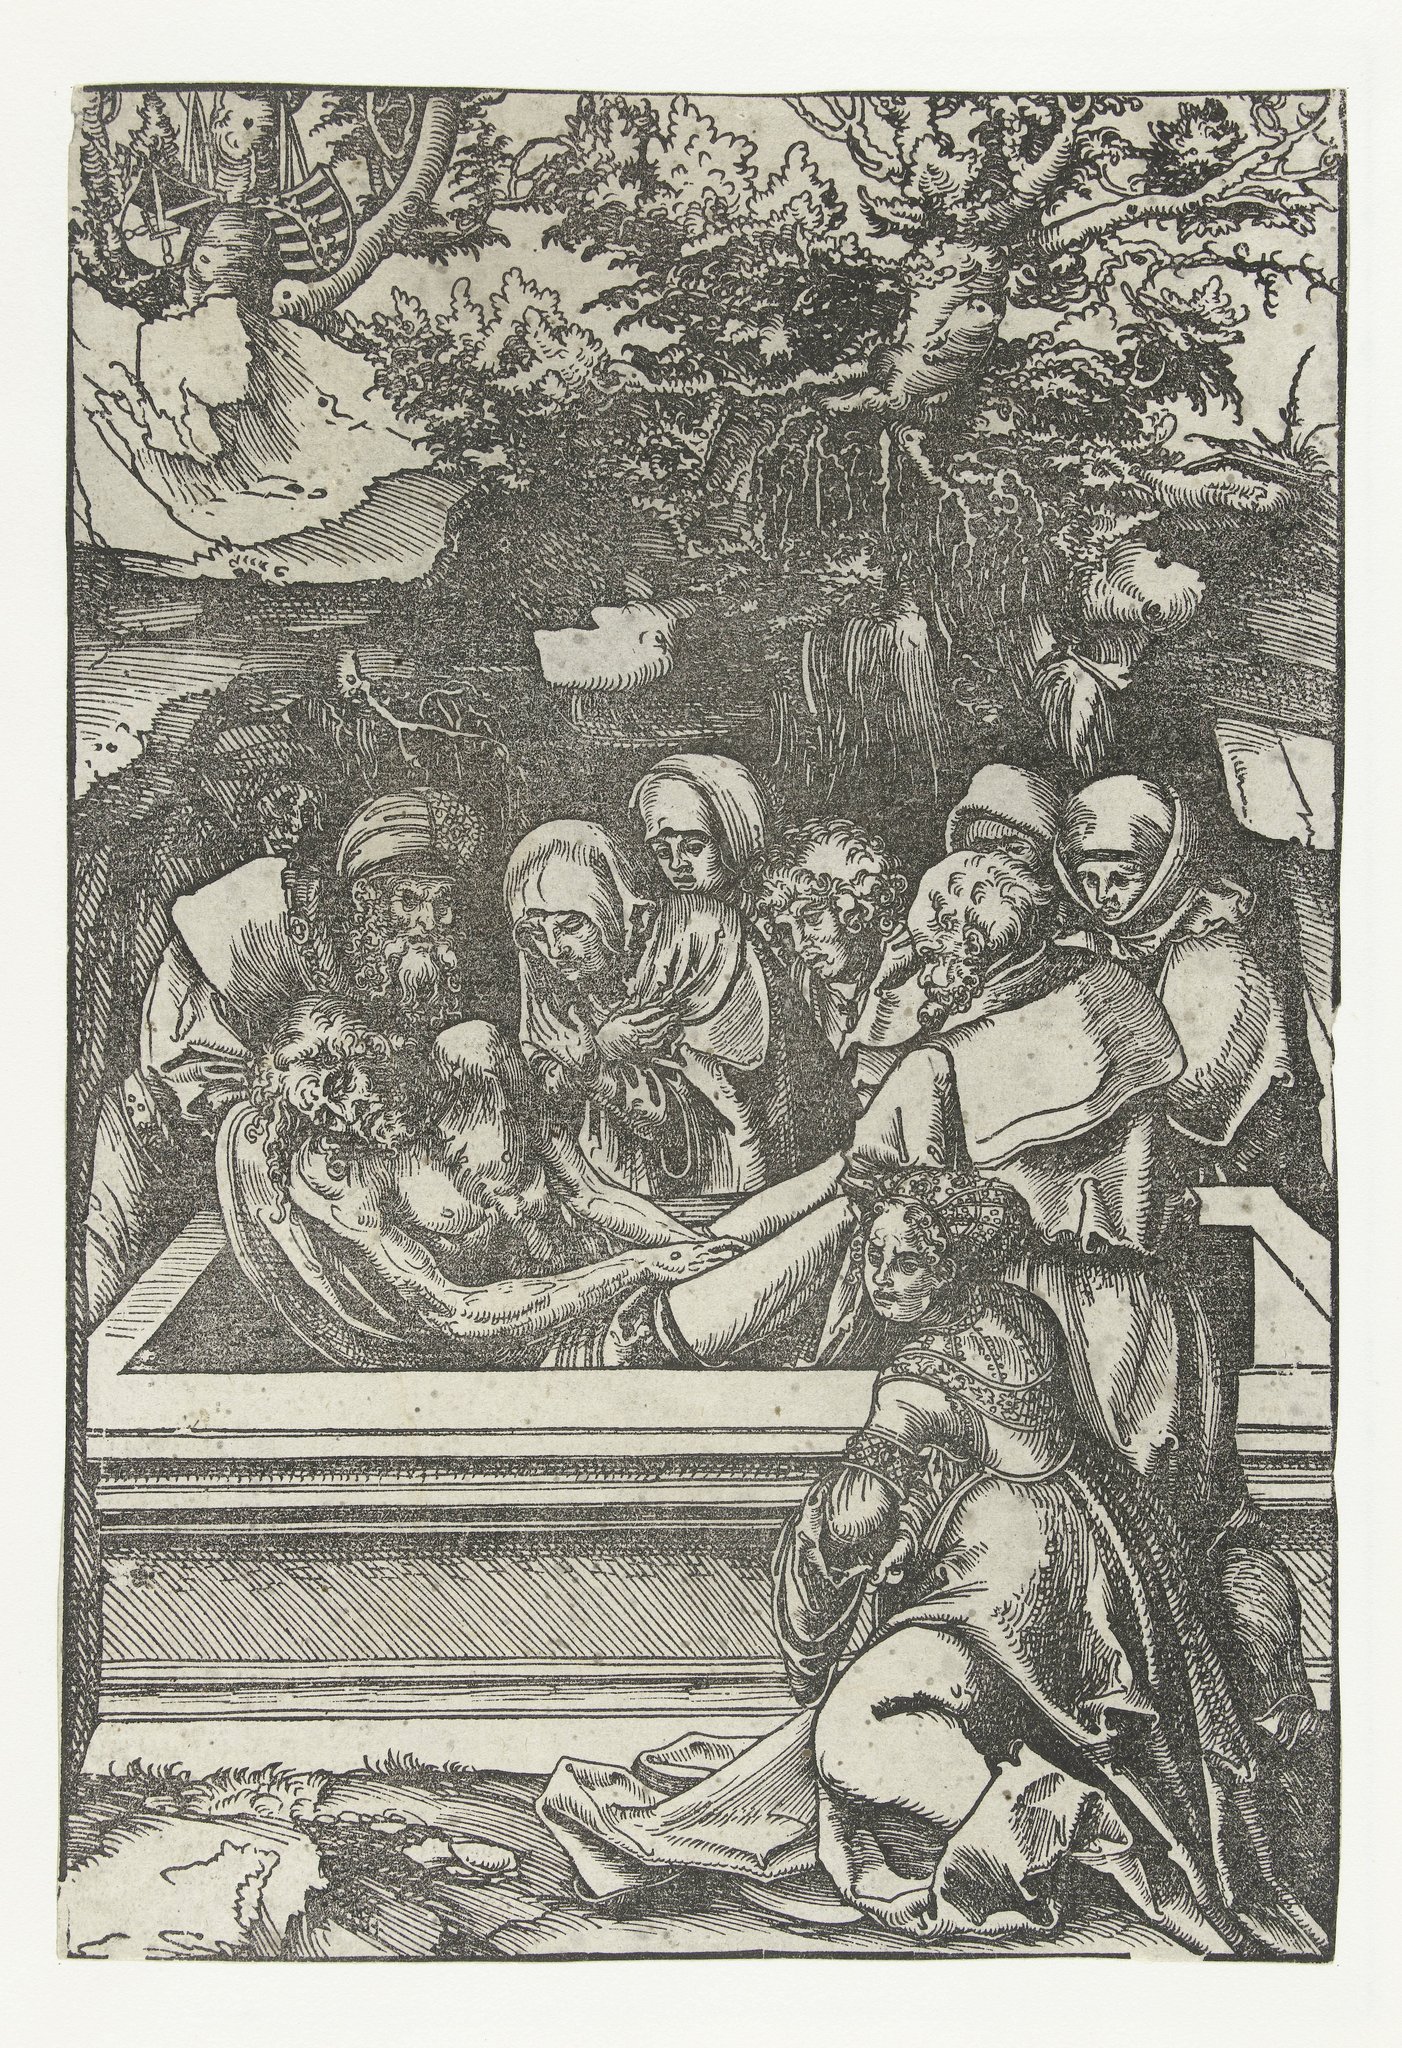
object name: print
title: Graflegging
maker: lucas cranach (i)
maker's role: draughtsman, print maker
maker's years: 1472-1553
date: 1509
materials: paper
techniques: woodcut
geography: germany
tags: christ's entombment (possibly by angels)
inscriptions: collector's mark: Lugt 2228a, collector's mark: Lugt 240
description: Het dode lichaam van Christus wordt door Jozef van Arimatea en Nikodemus met een doek in het graf gelegd. Maria en Johannes buigen zich over het graf. Maria Magdalena knielt voor het graf. Linksboven in een boom hangen twee schilden met het keurvorstelijk en hertogelijk wapen van Saksen.